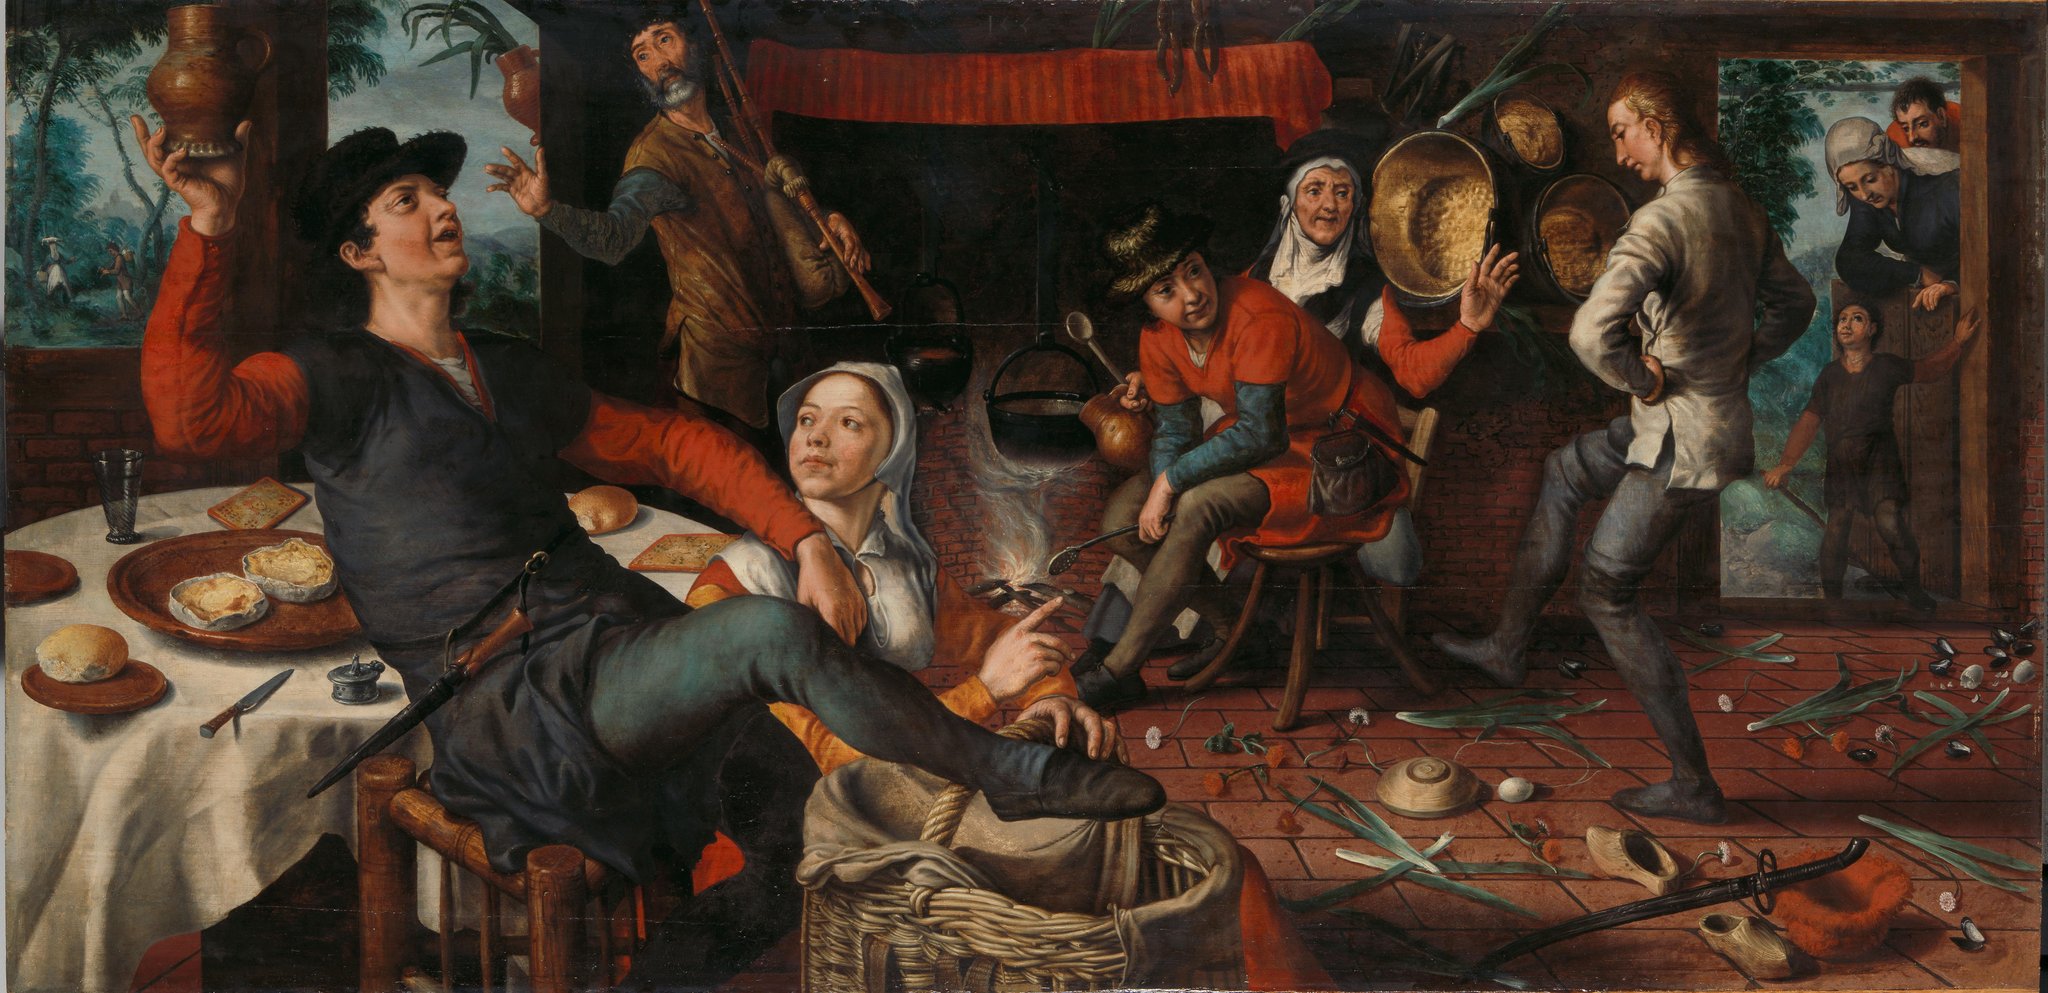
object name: painting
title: The Egg Dance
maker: pieter aertsen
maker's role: draughtsman, painter, print maker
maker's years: 1508-1575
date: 1552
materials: oil, panel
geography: antwerp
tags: interior of the house, man dancing alone, festivities (+ games of skill ~ festive activities)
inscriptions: date, top centre on the fire place: ‘1552’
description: At right, in this brothel, a young man does an egg dance to the music of a bagpiper. While dancing, he had to roll an egg within a chalk circle – without it breaking – and to cover it with a wooden bowl. This ‘pointless’ amusement, along with the dissolute behaviour of the other figures, served as a moral warning against debauchery.